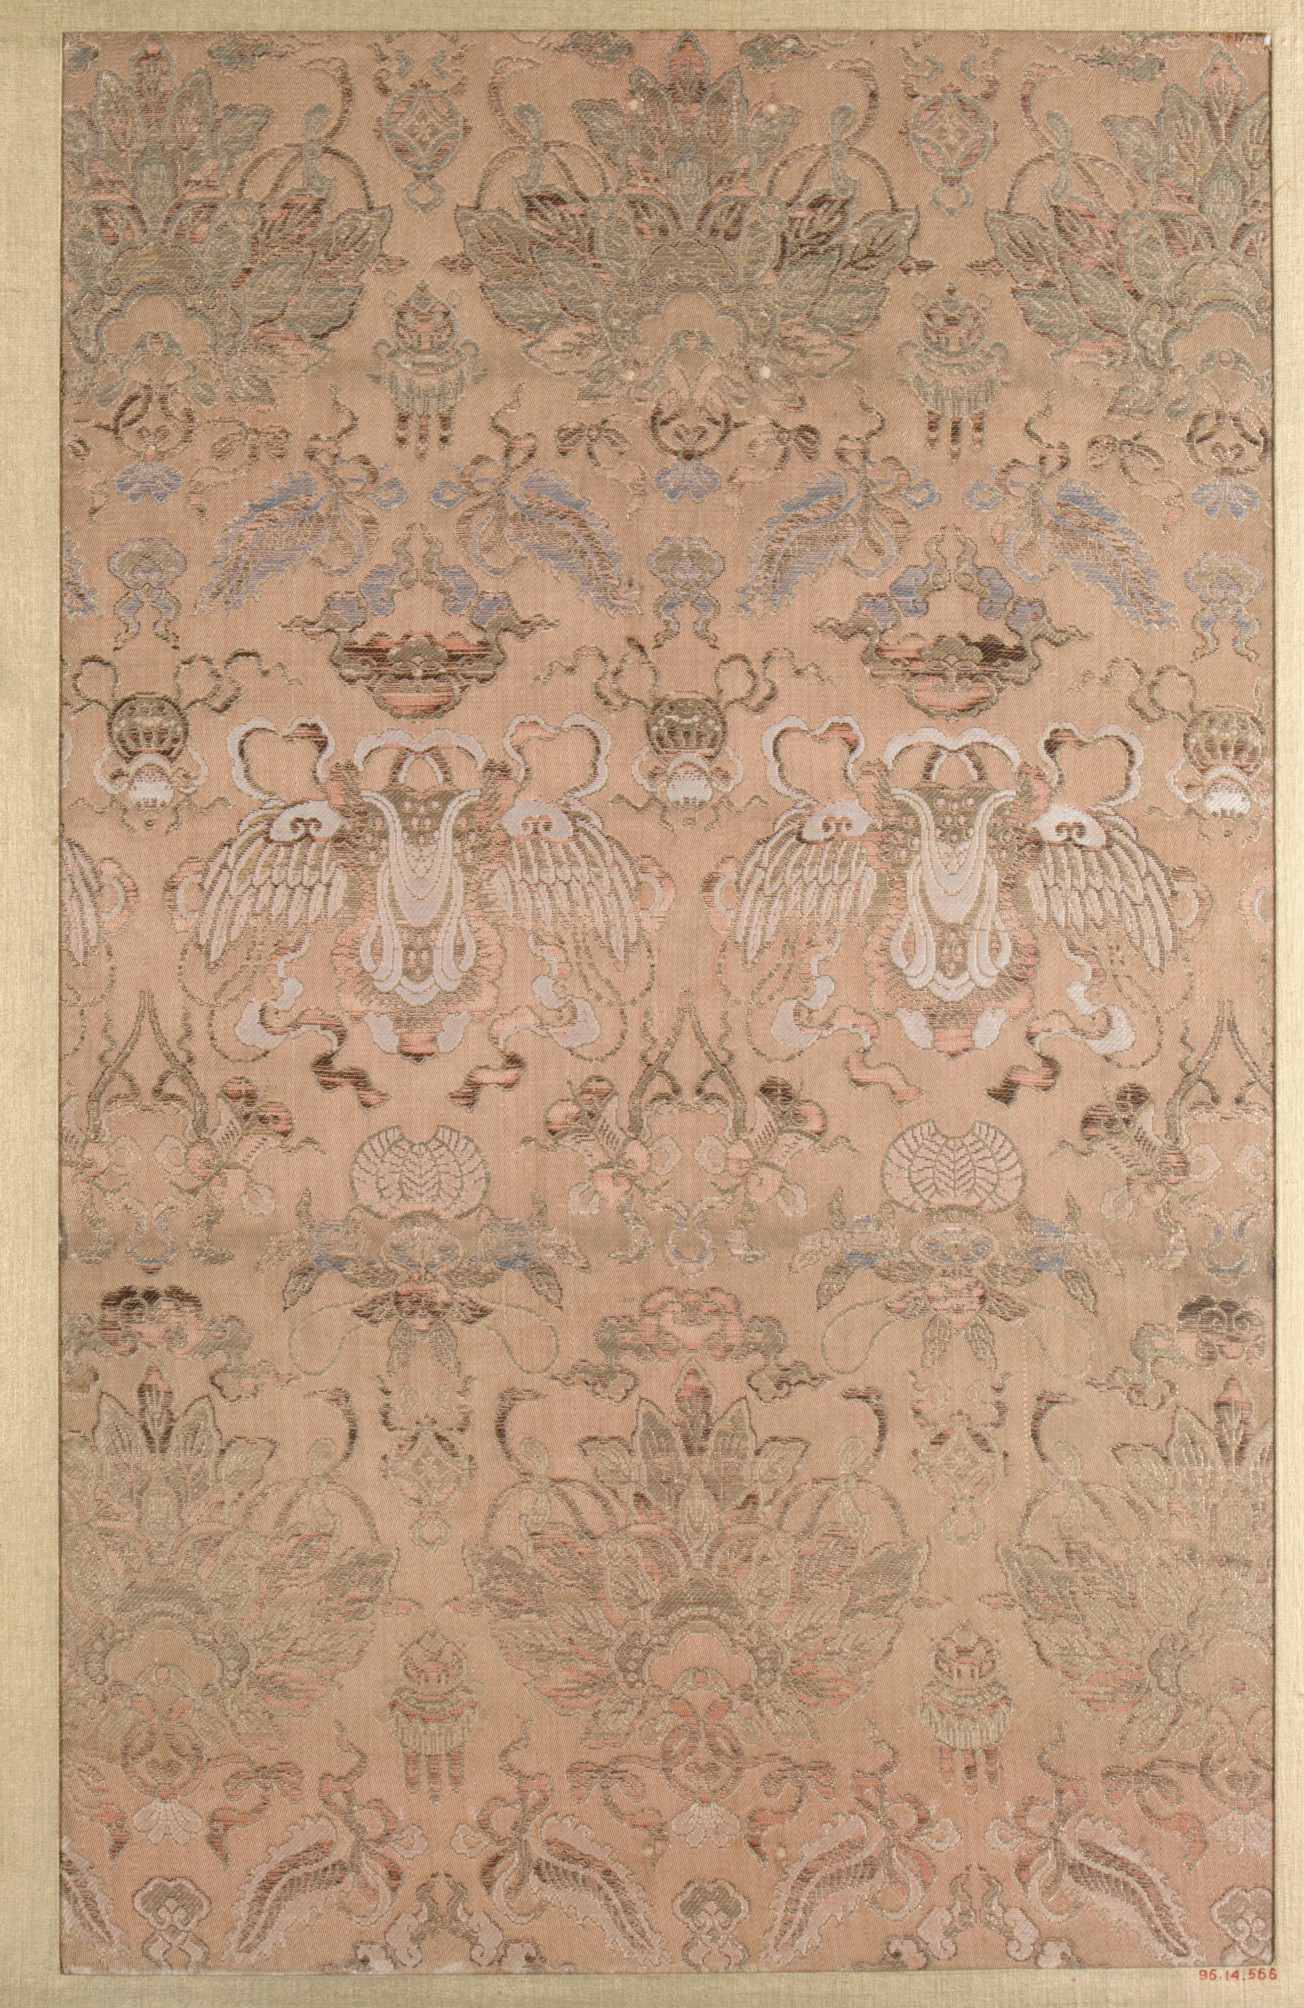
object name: piece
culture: japanese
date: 1701-1900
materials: silk